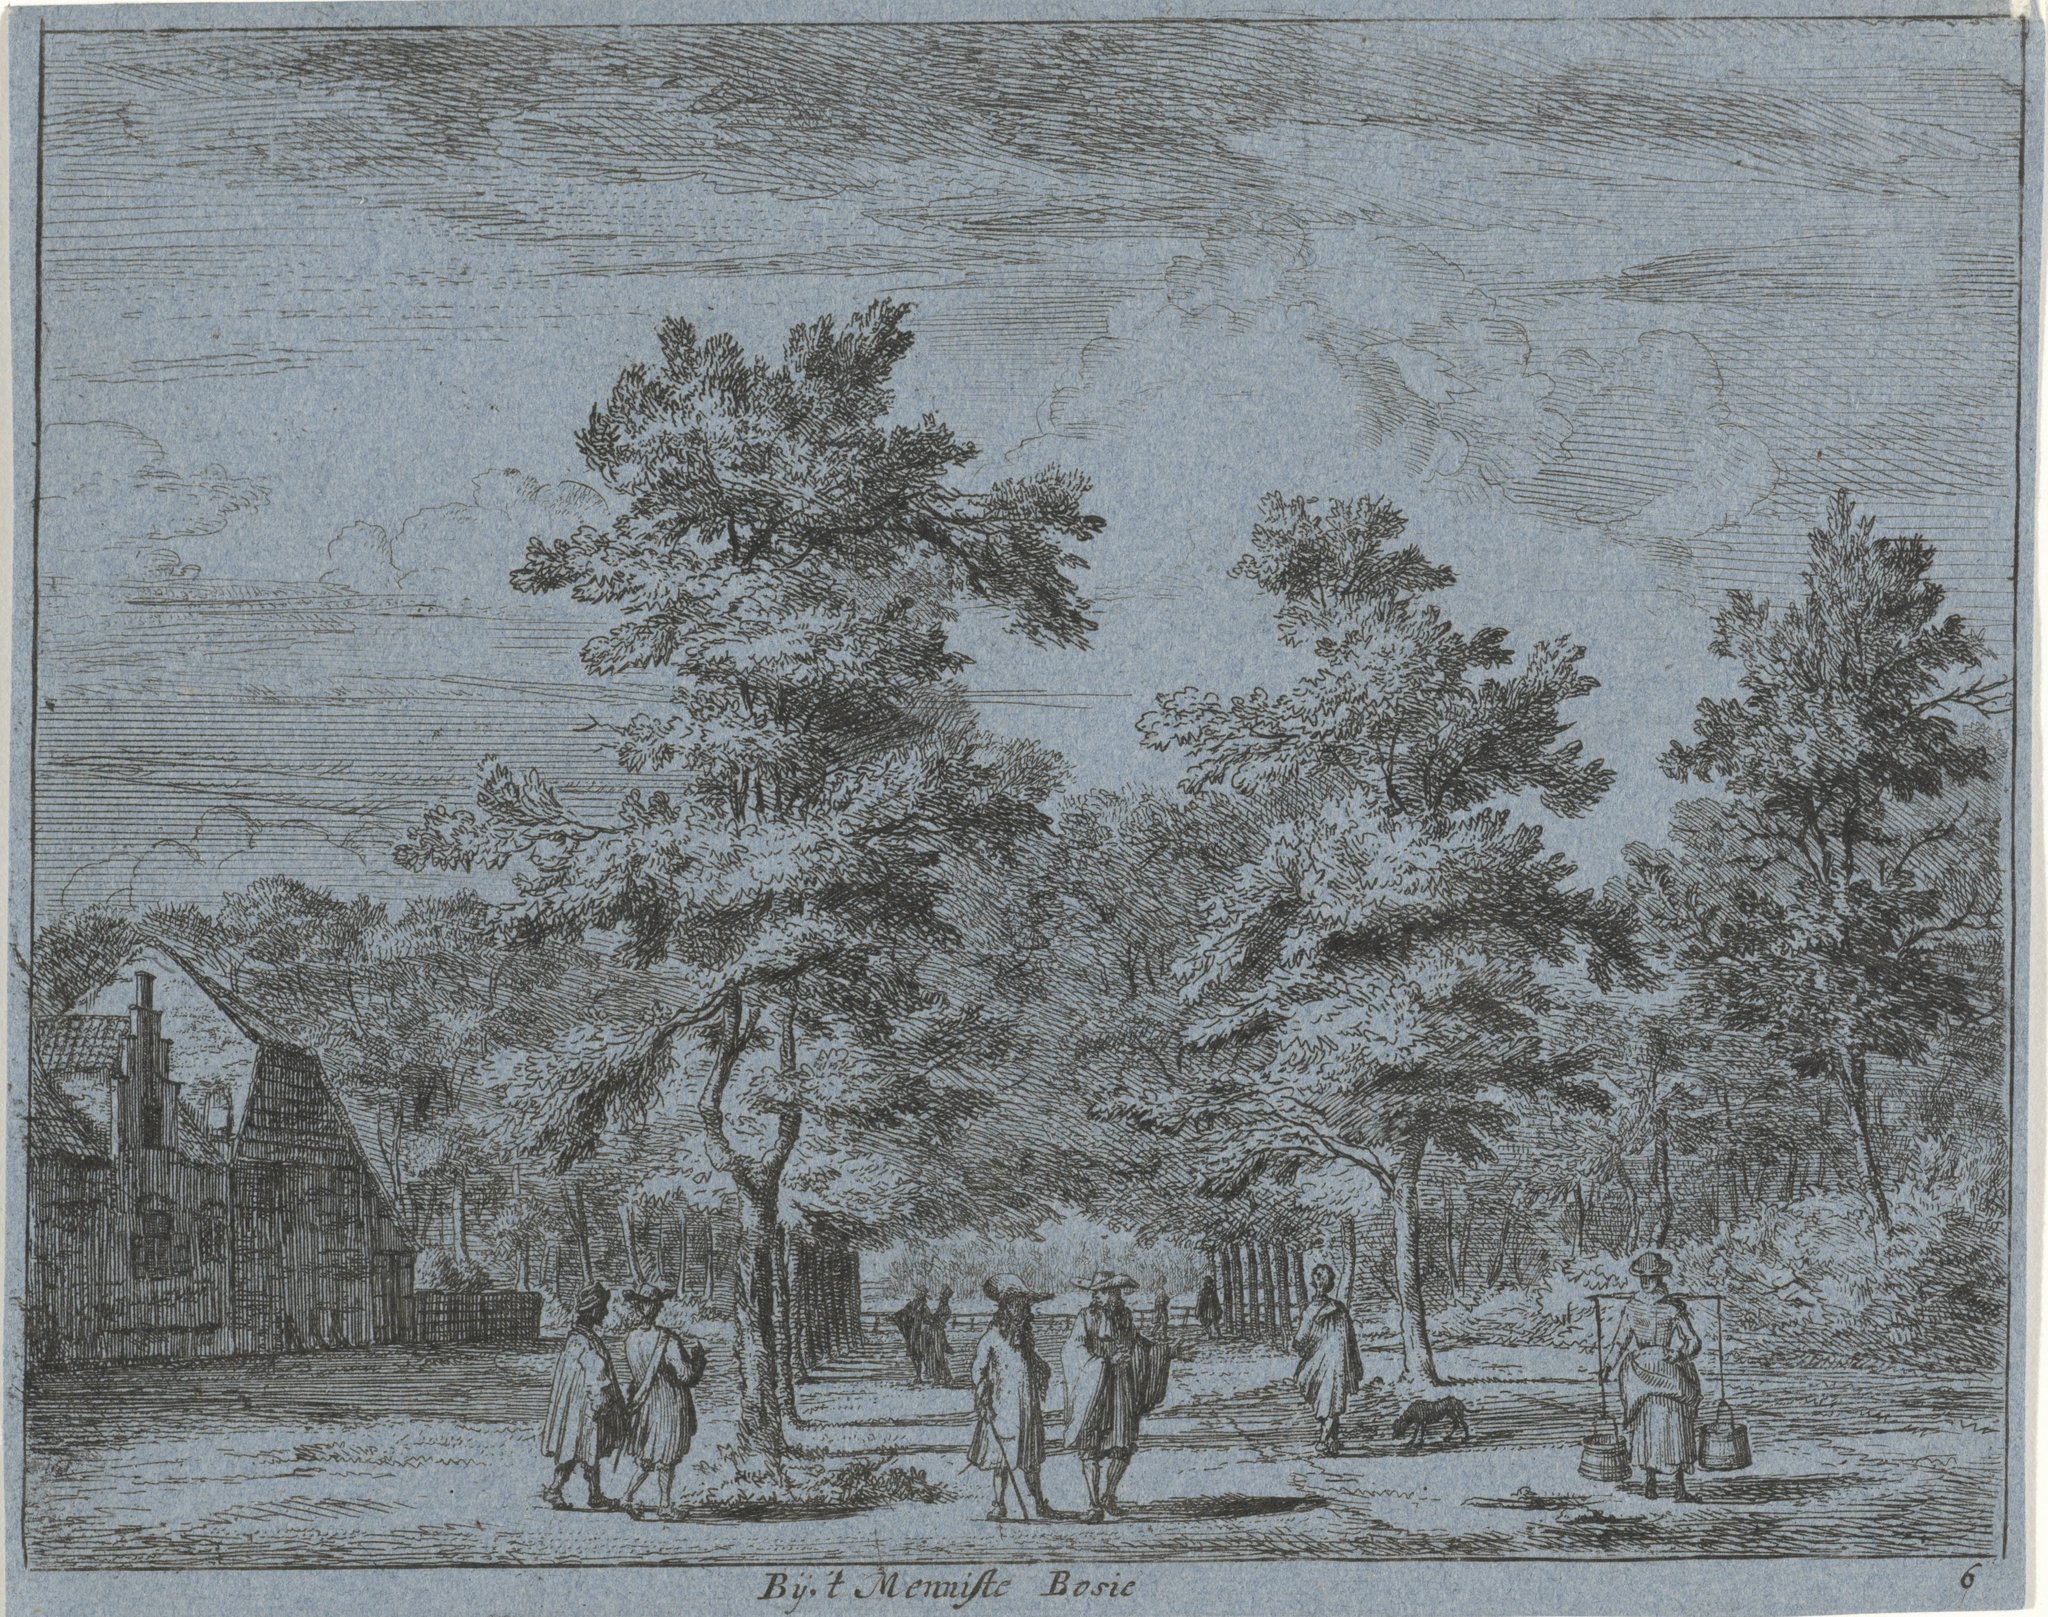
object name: print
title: Wandelende figuren op een laan met bomen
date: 1688-1721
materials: paper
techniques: etching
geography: haarlem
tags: trees, carrying something with yoke, forest path or lane (+ landscape with figures, staffage), milkmaid, haarlem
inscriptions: collector's mark: Lugt 2228, collector's mark: Lugt 240, collector's mark: Lugt 699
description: Wandelende figuren op een laan met bomen. Rechts een melkmeid met een juk.